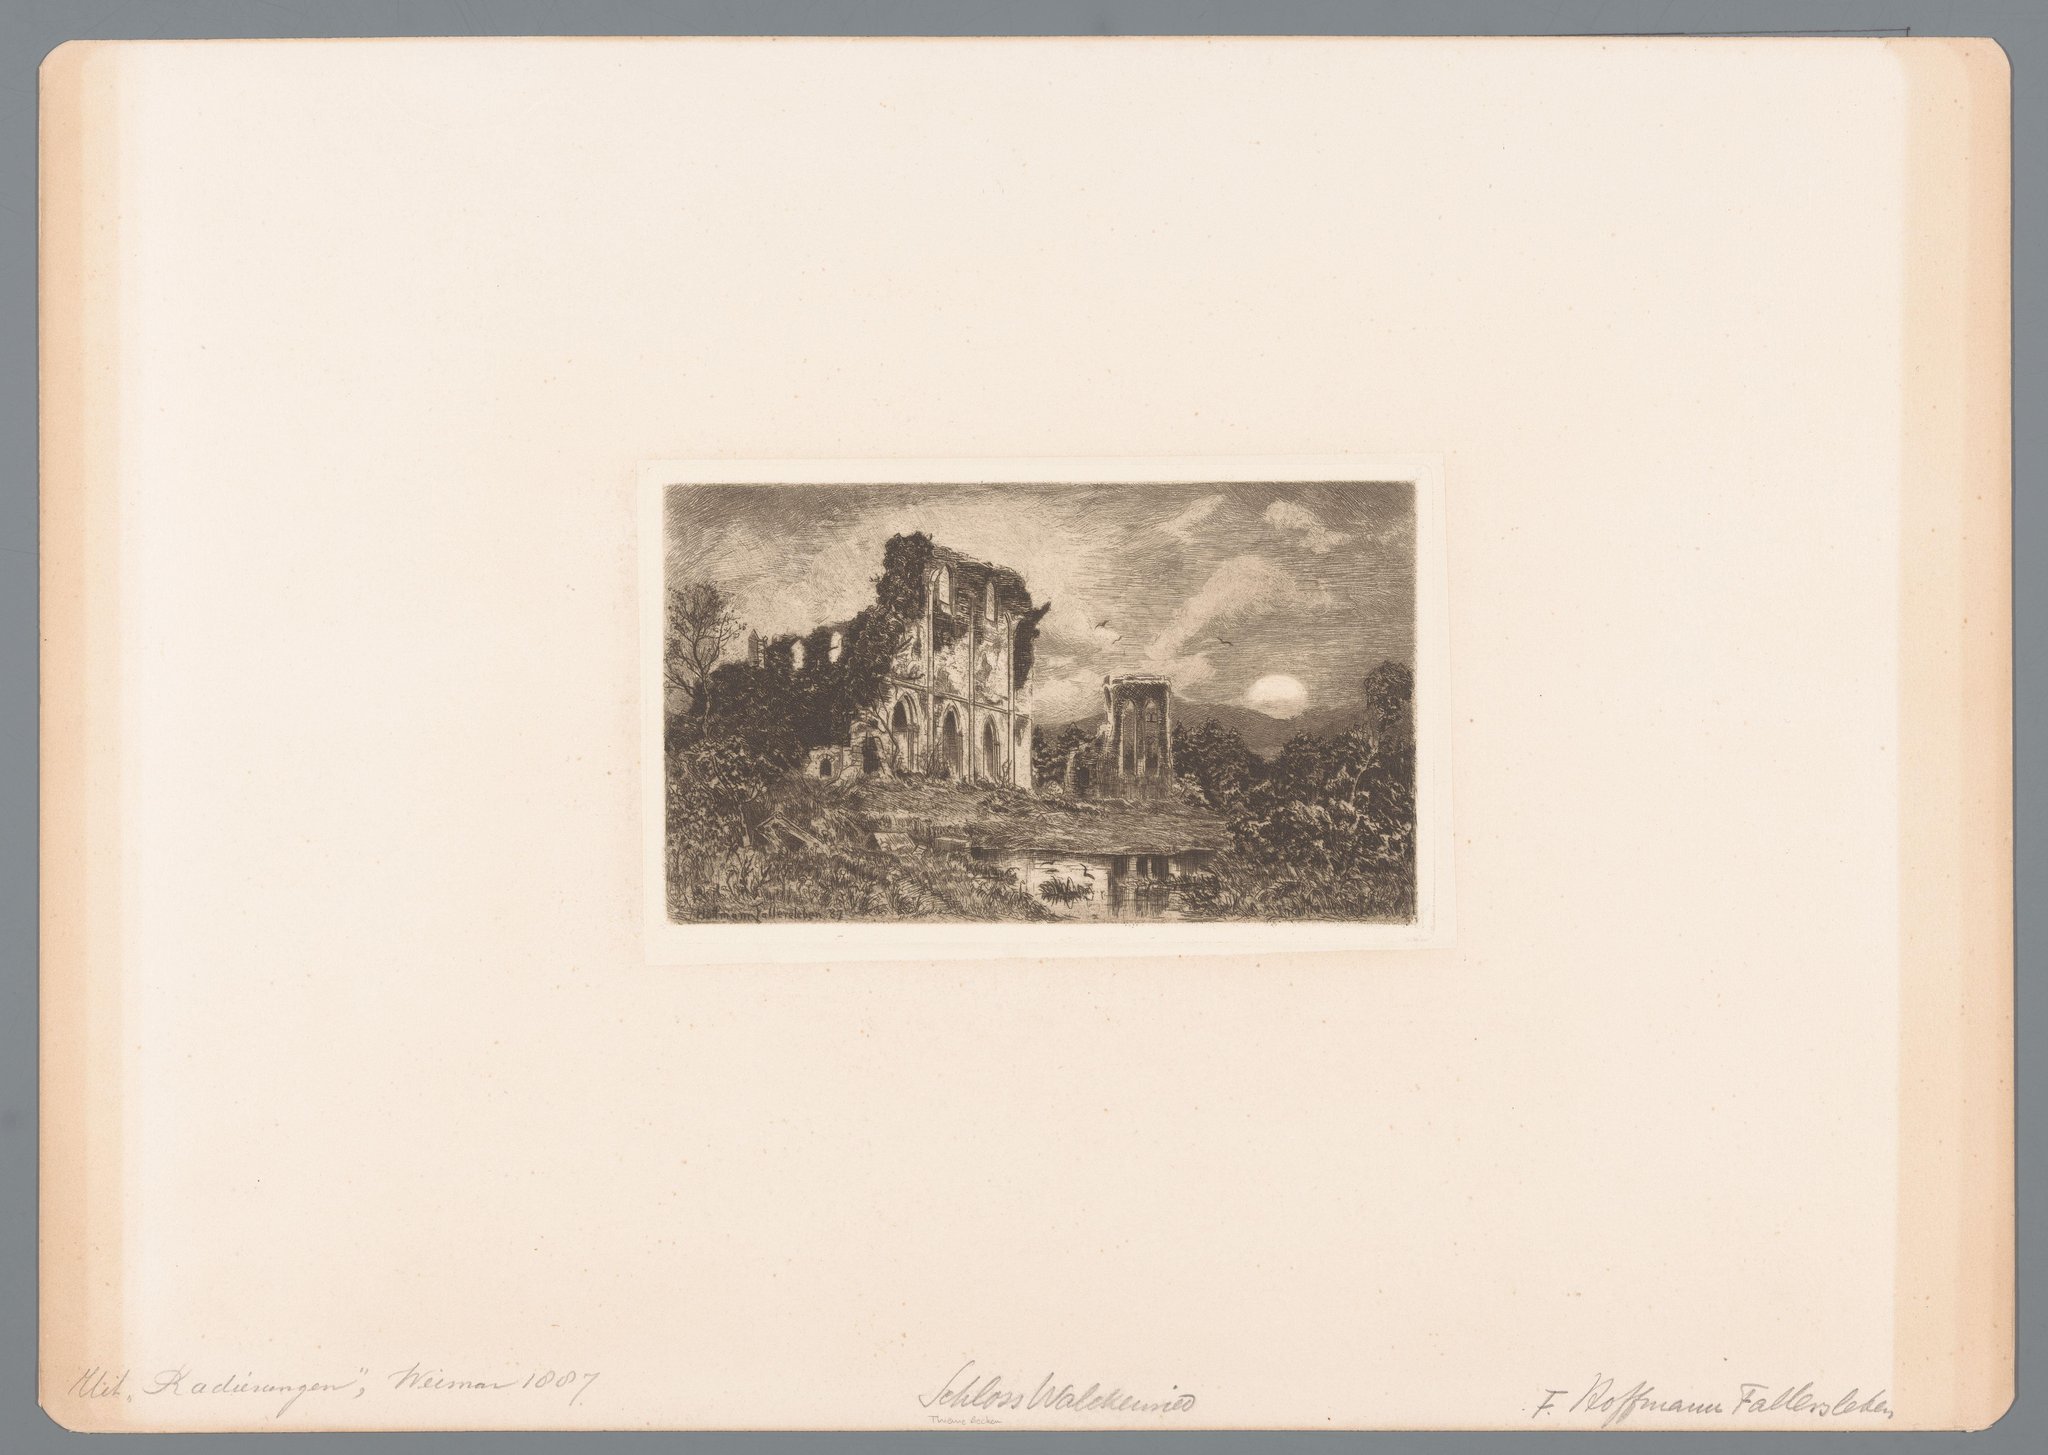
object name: print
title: Gezicht op de ruïnes van slot Walkenried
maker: franz hoffmann-fallersleben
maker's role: painter, print maker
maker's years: 1855-1924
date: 1887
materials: paper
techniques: etching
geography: weimar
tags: moonrise, landscape with ruins, pond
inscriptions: collector's mark: Lugt 2228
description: Prent uit: Radirungen. Weimar: Gesellschaft für Radierkunst zu Weimar, 1887.